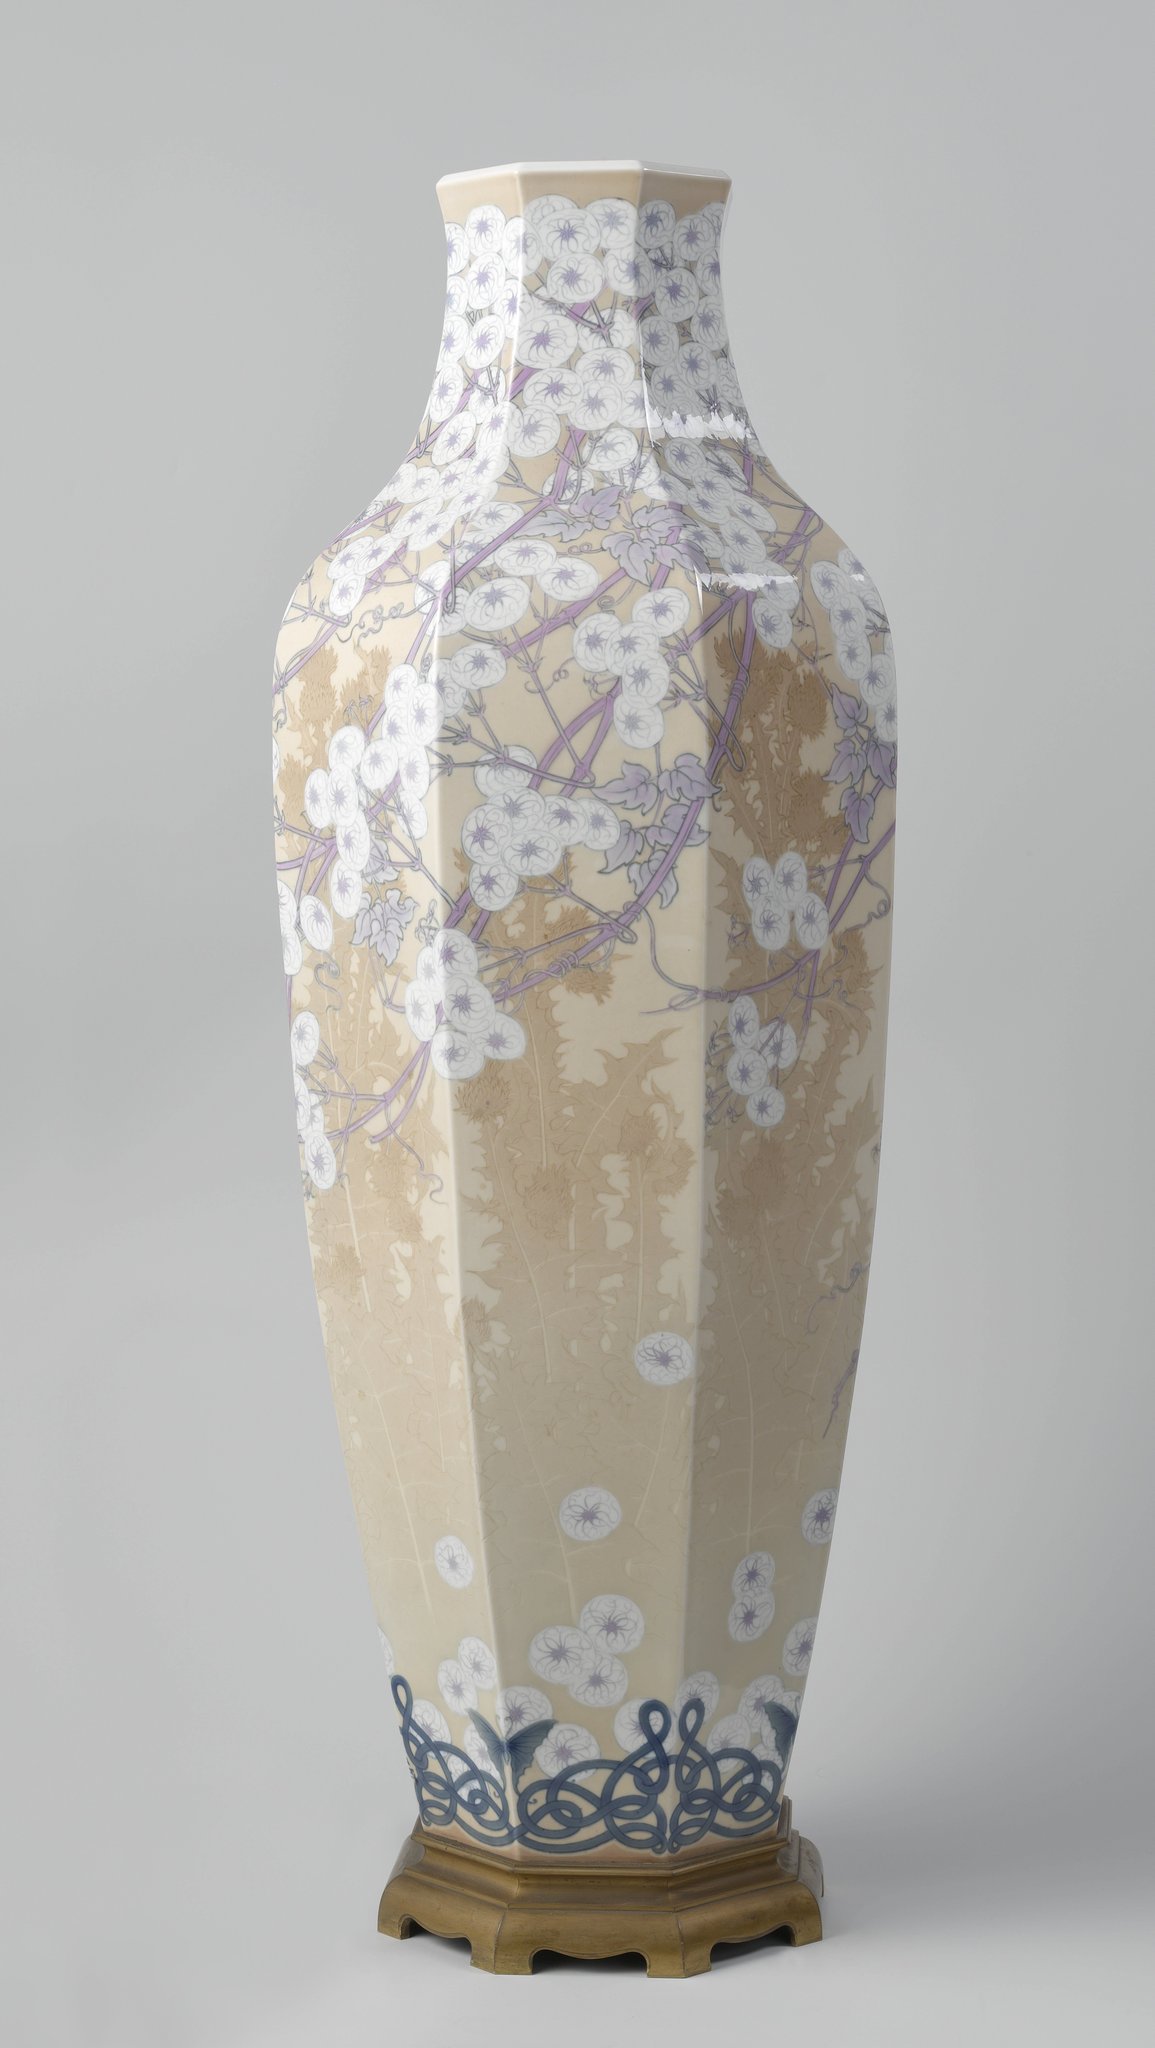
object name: foot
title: Vase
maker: léonard gébleux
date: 1908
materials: bronze, porcelain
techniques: gilding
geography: sèvres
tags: flowers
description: The Sèvres porcelain factory (1738) always tried to keep up with the times. By attracting modern artists, it ensured a supply of fresh, contemporary designs. This impressively tall vase is a fine example of innovations at Sèvres. The ornamentation of white and purple clematis with ochre-coloured thistles and the butterflies on the decora-tive railing at bottom reflect the influence of Japanese art, which was then extremely popular.